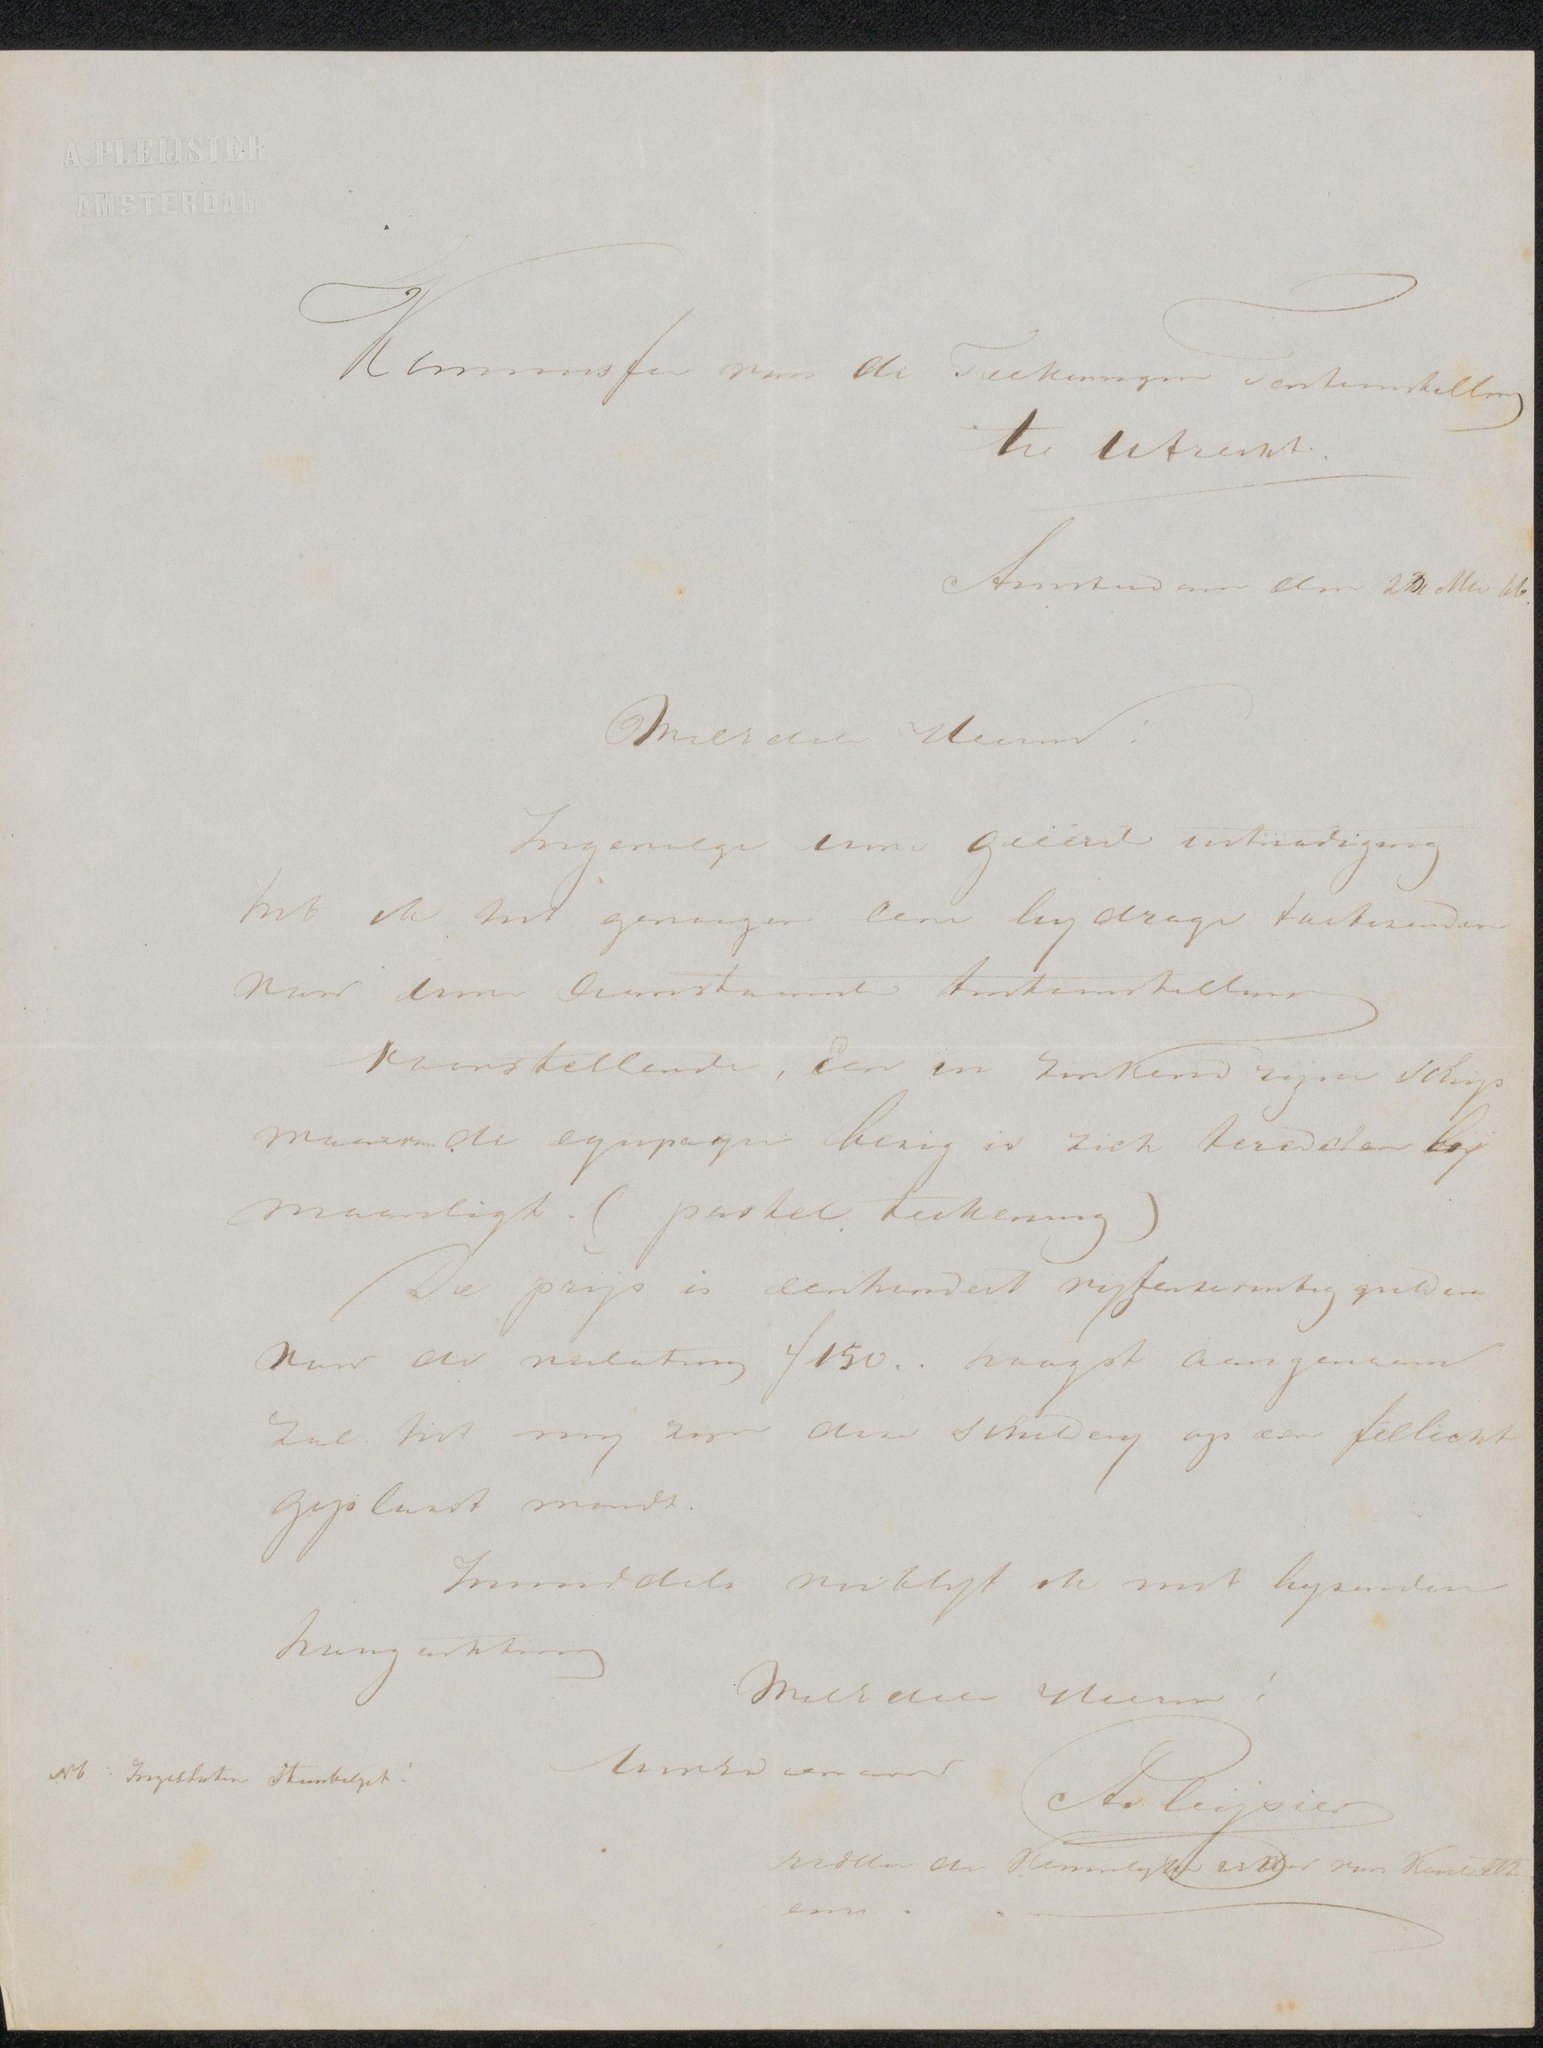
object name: letter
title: Brief aan de Commissie van de Tentoonstelling van Levende Meesters in Utrecht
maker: ary pleijsier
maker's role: draughtsman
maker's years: 1819-1879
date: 1866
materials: ink, paper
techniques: pen, writing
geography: the hague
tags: drawing, exhibition ~ art, money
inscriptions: name: ‘A. PLEIJSIER AMSTERDAM’